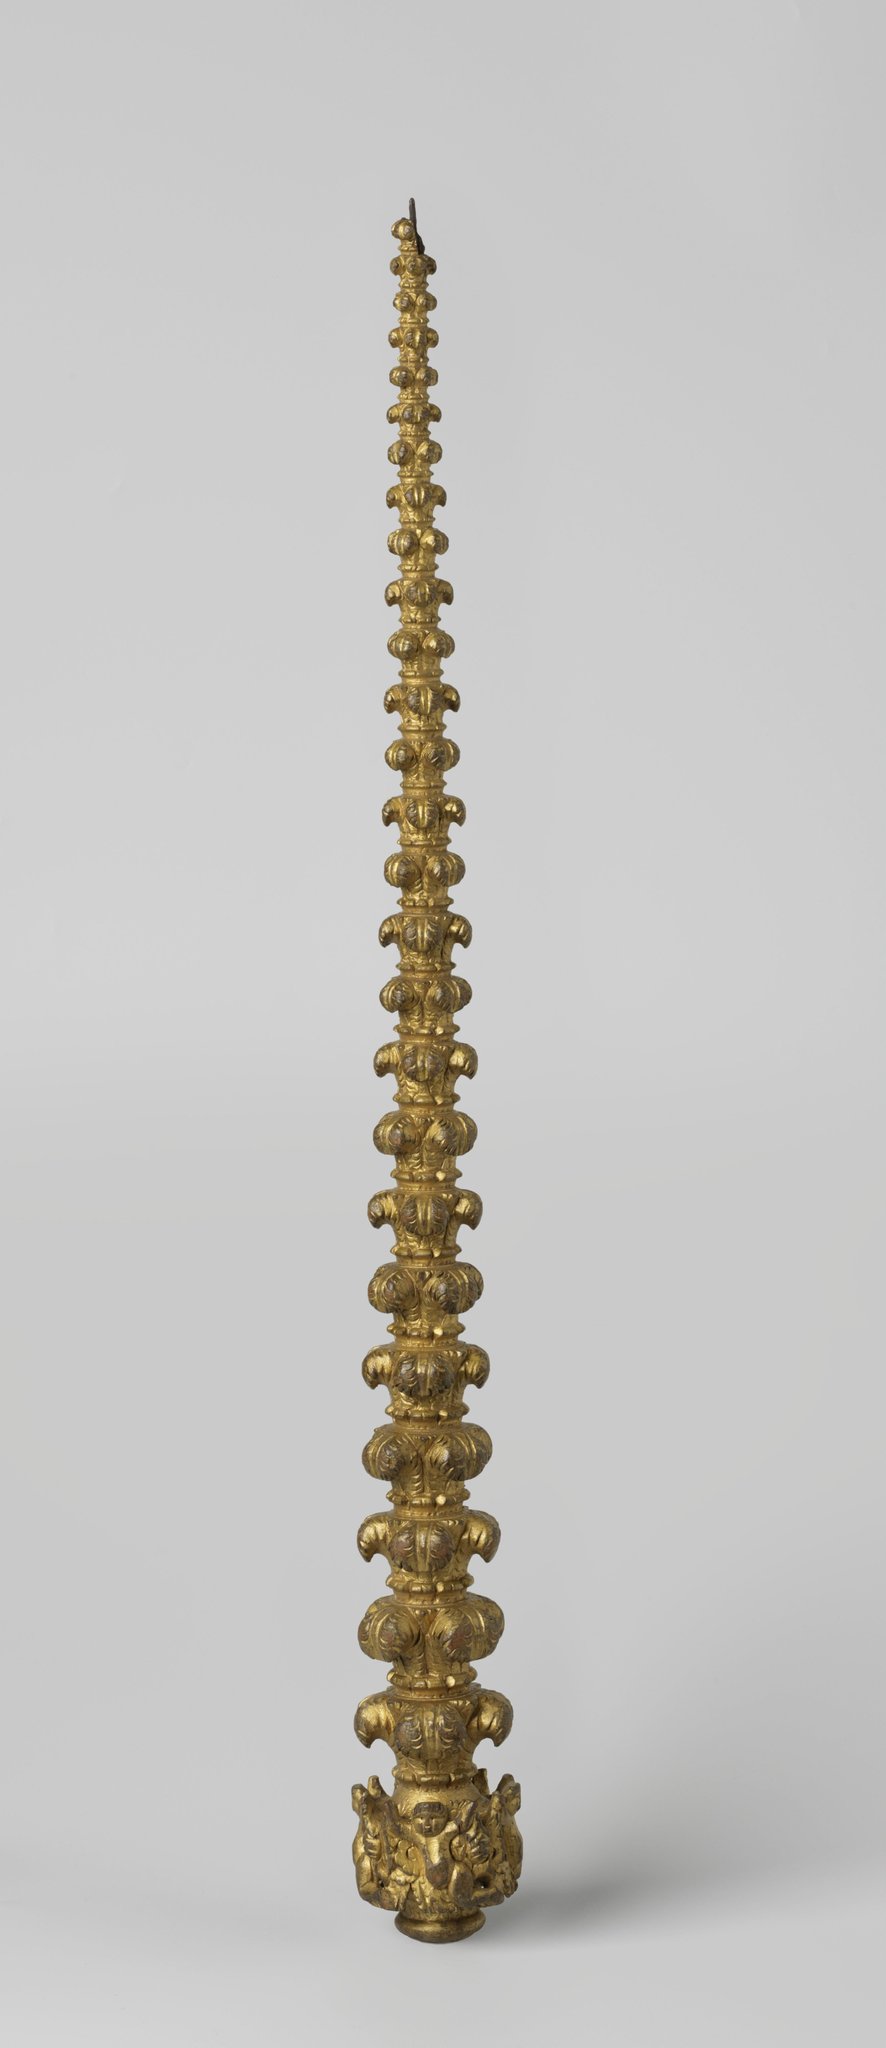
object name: mastwortel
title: Mastwortel van een binnenvaartschip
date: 1700-1800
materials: iron, wood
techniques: cutting, gilding, turning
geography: netherlands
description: Vergulde mastwortel met 27 geledingen. Elke geleding bestaat uit vier naar beneden krullende veren. Onderstuk waarop vier putti met de armen omhoog. Onderin rond gat; bovenaan bekroning afgebroken, waardoor ijzeren pin zichtbaar is geworden.